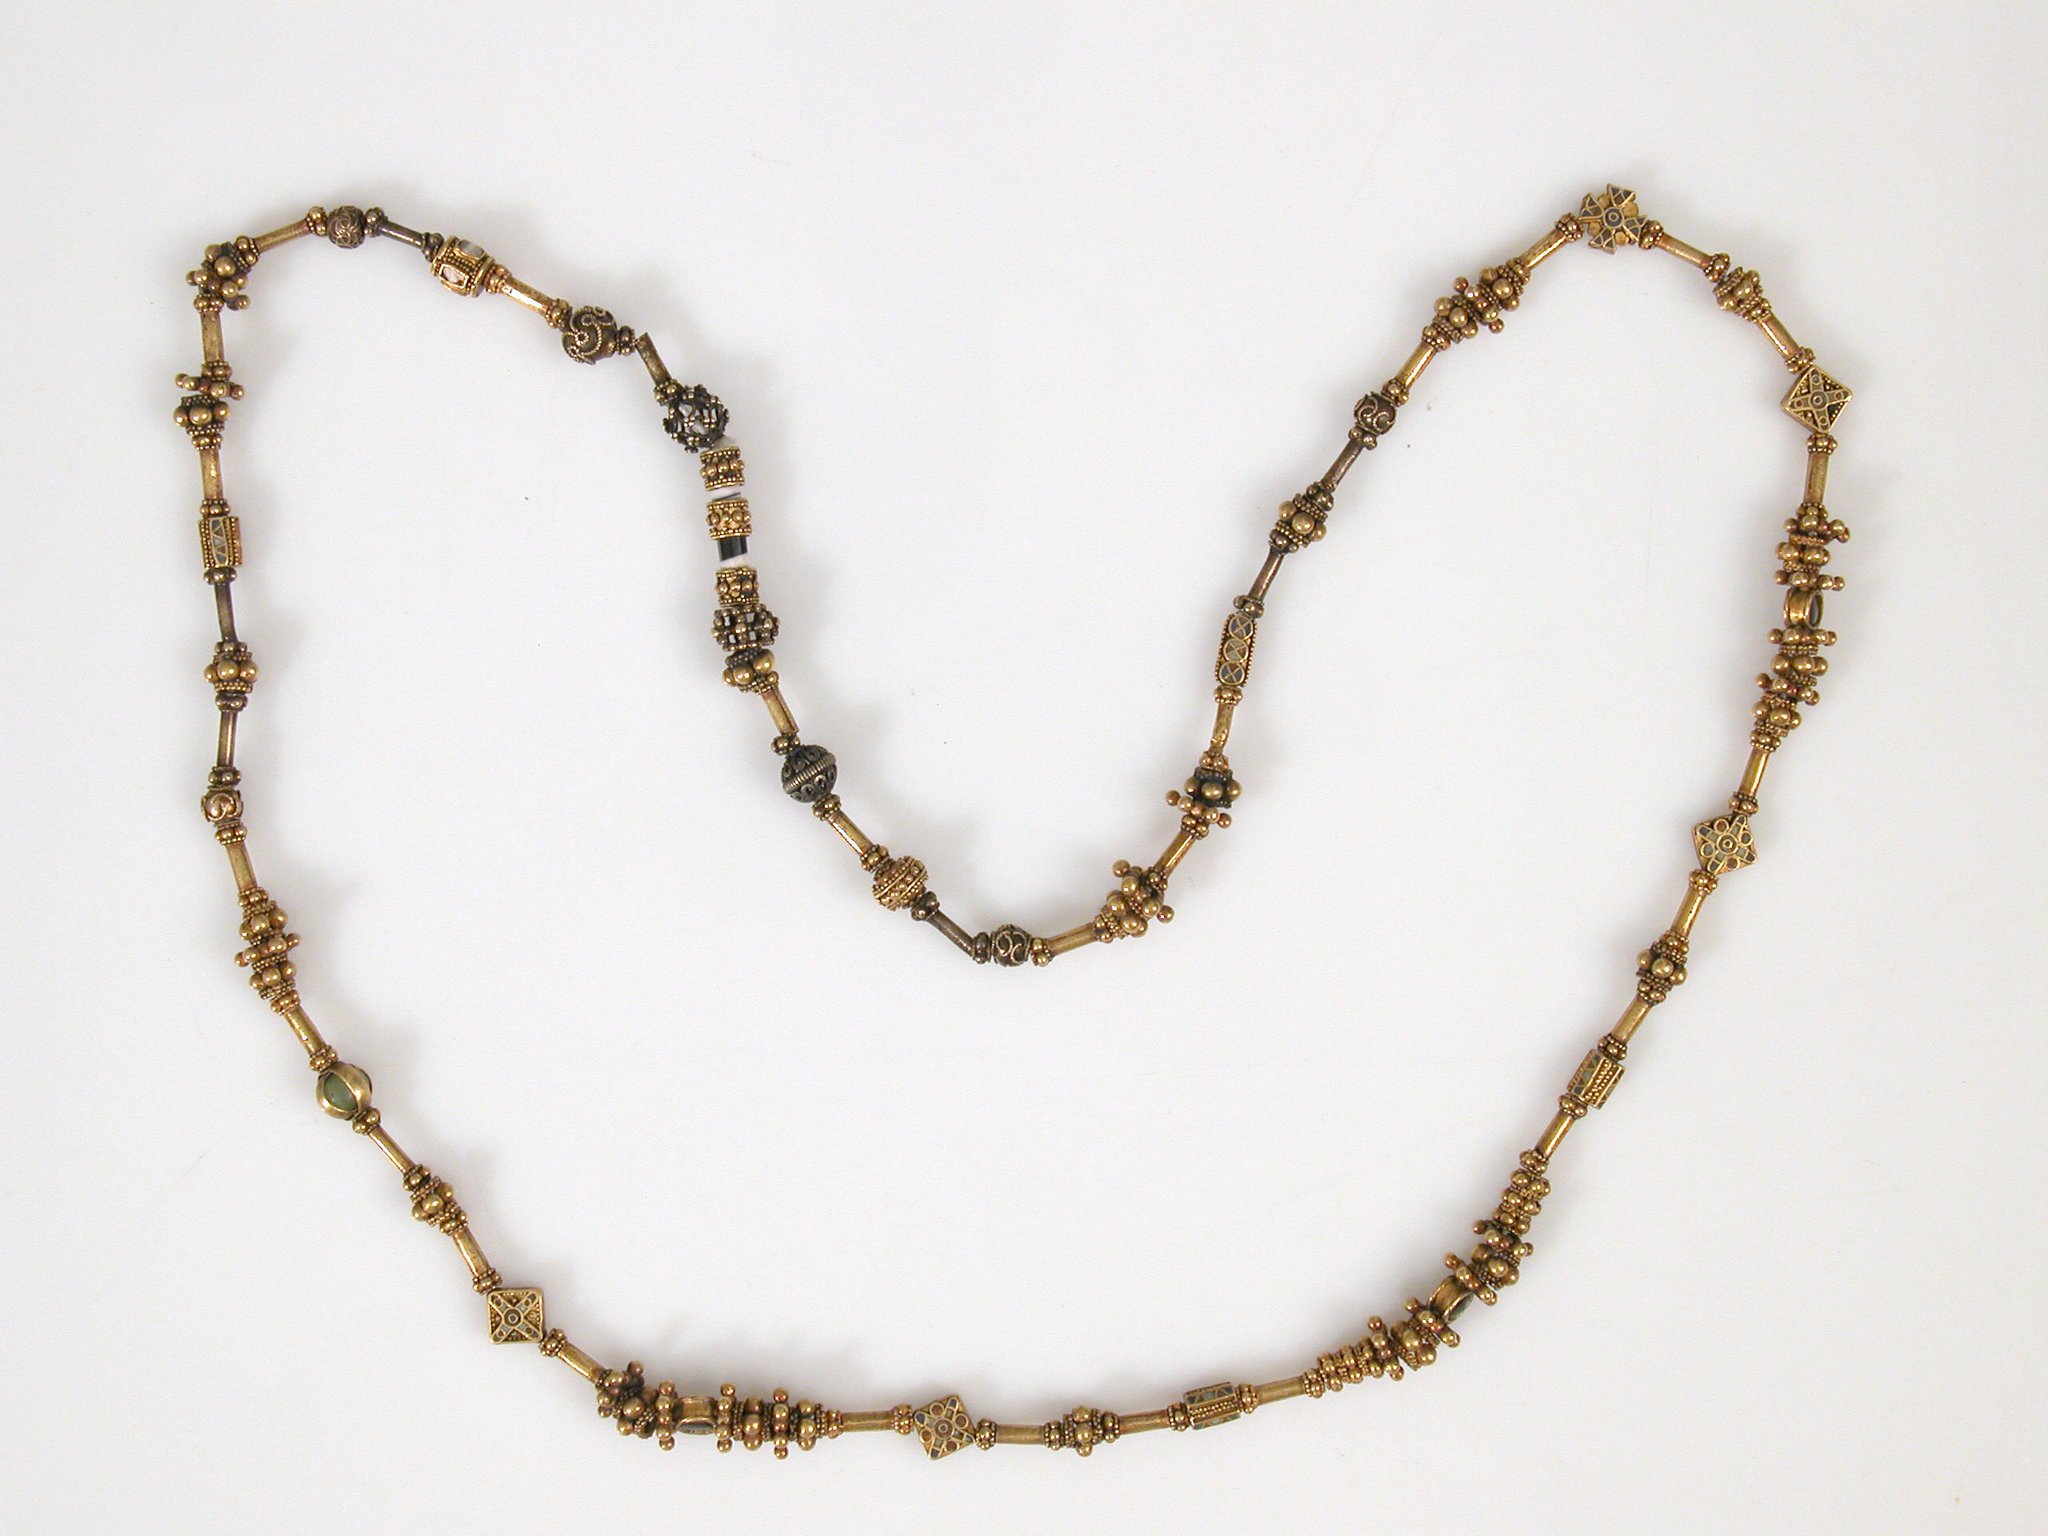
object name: necklace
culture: byzantine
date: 901-1000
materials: enamel, gold, stone